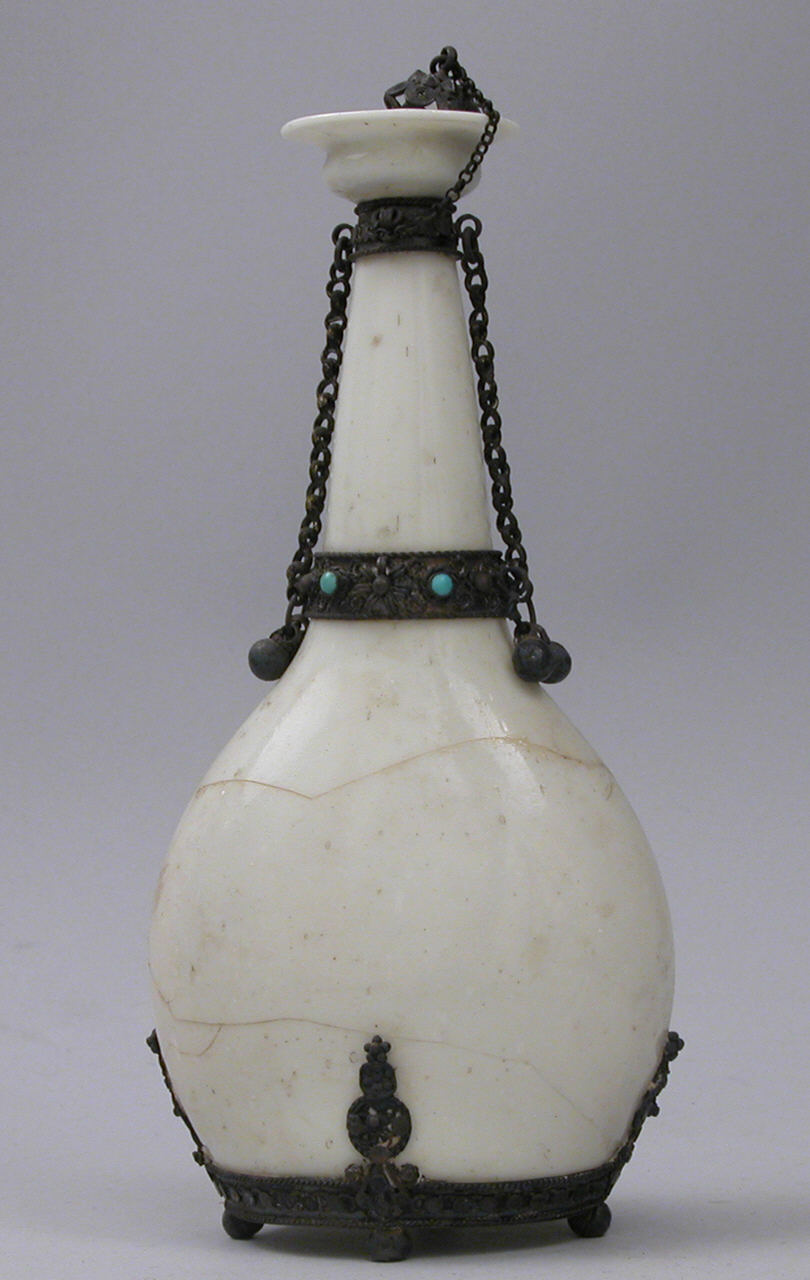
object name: bottle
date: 1701-1900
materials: glass, silver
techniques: glassblowing, tooling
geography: iran